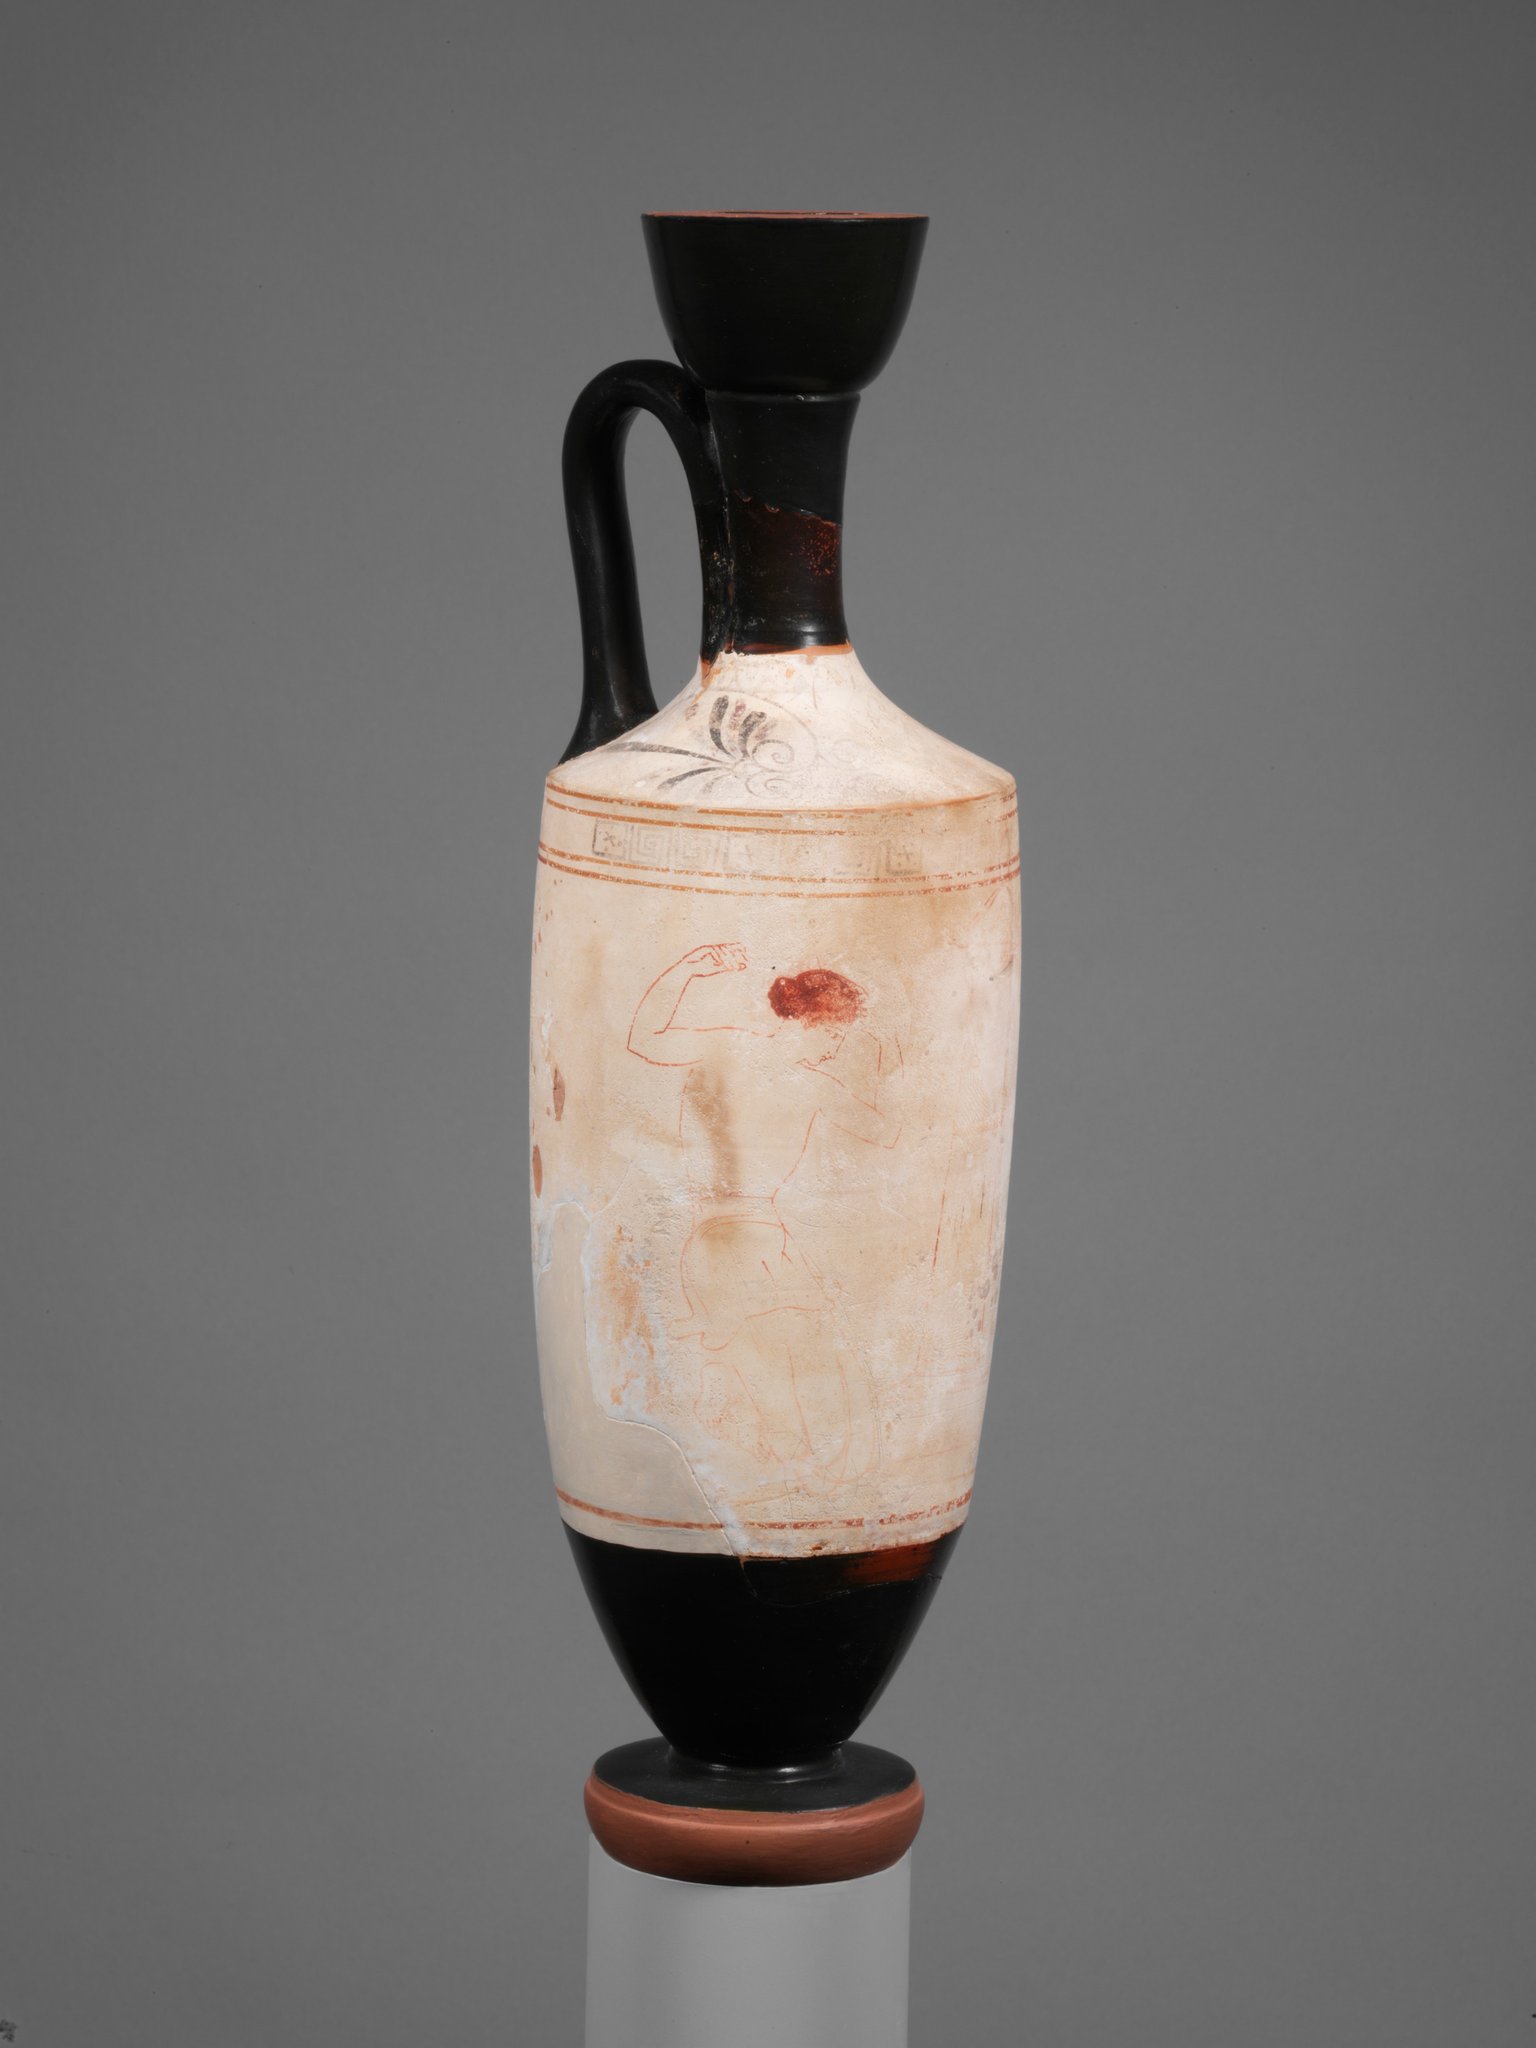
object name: lekythos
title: Terracotta lekythos (oil flask)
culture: greek, attic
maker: quadrate painter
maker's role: artist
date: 420 BCE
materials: terracotta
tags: helmets,spears,men,women